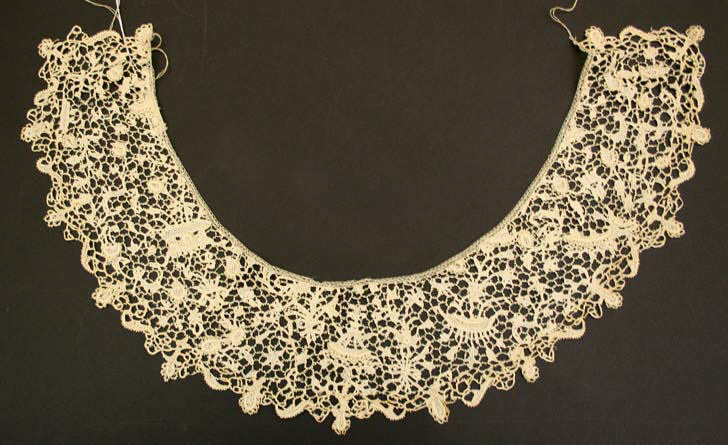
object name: collar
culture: french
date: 1701-1725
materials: linen